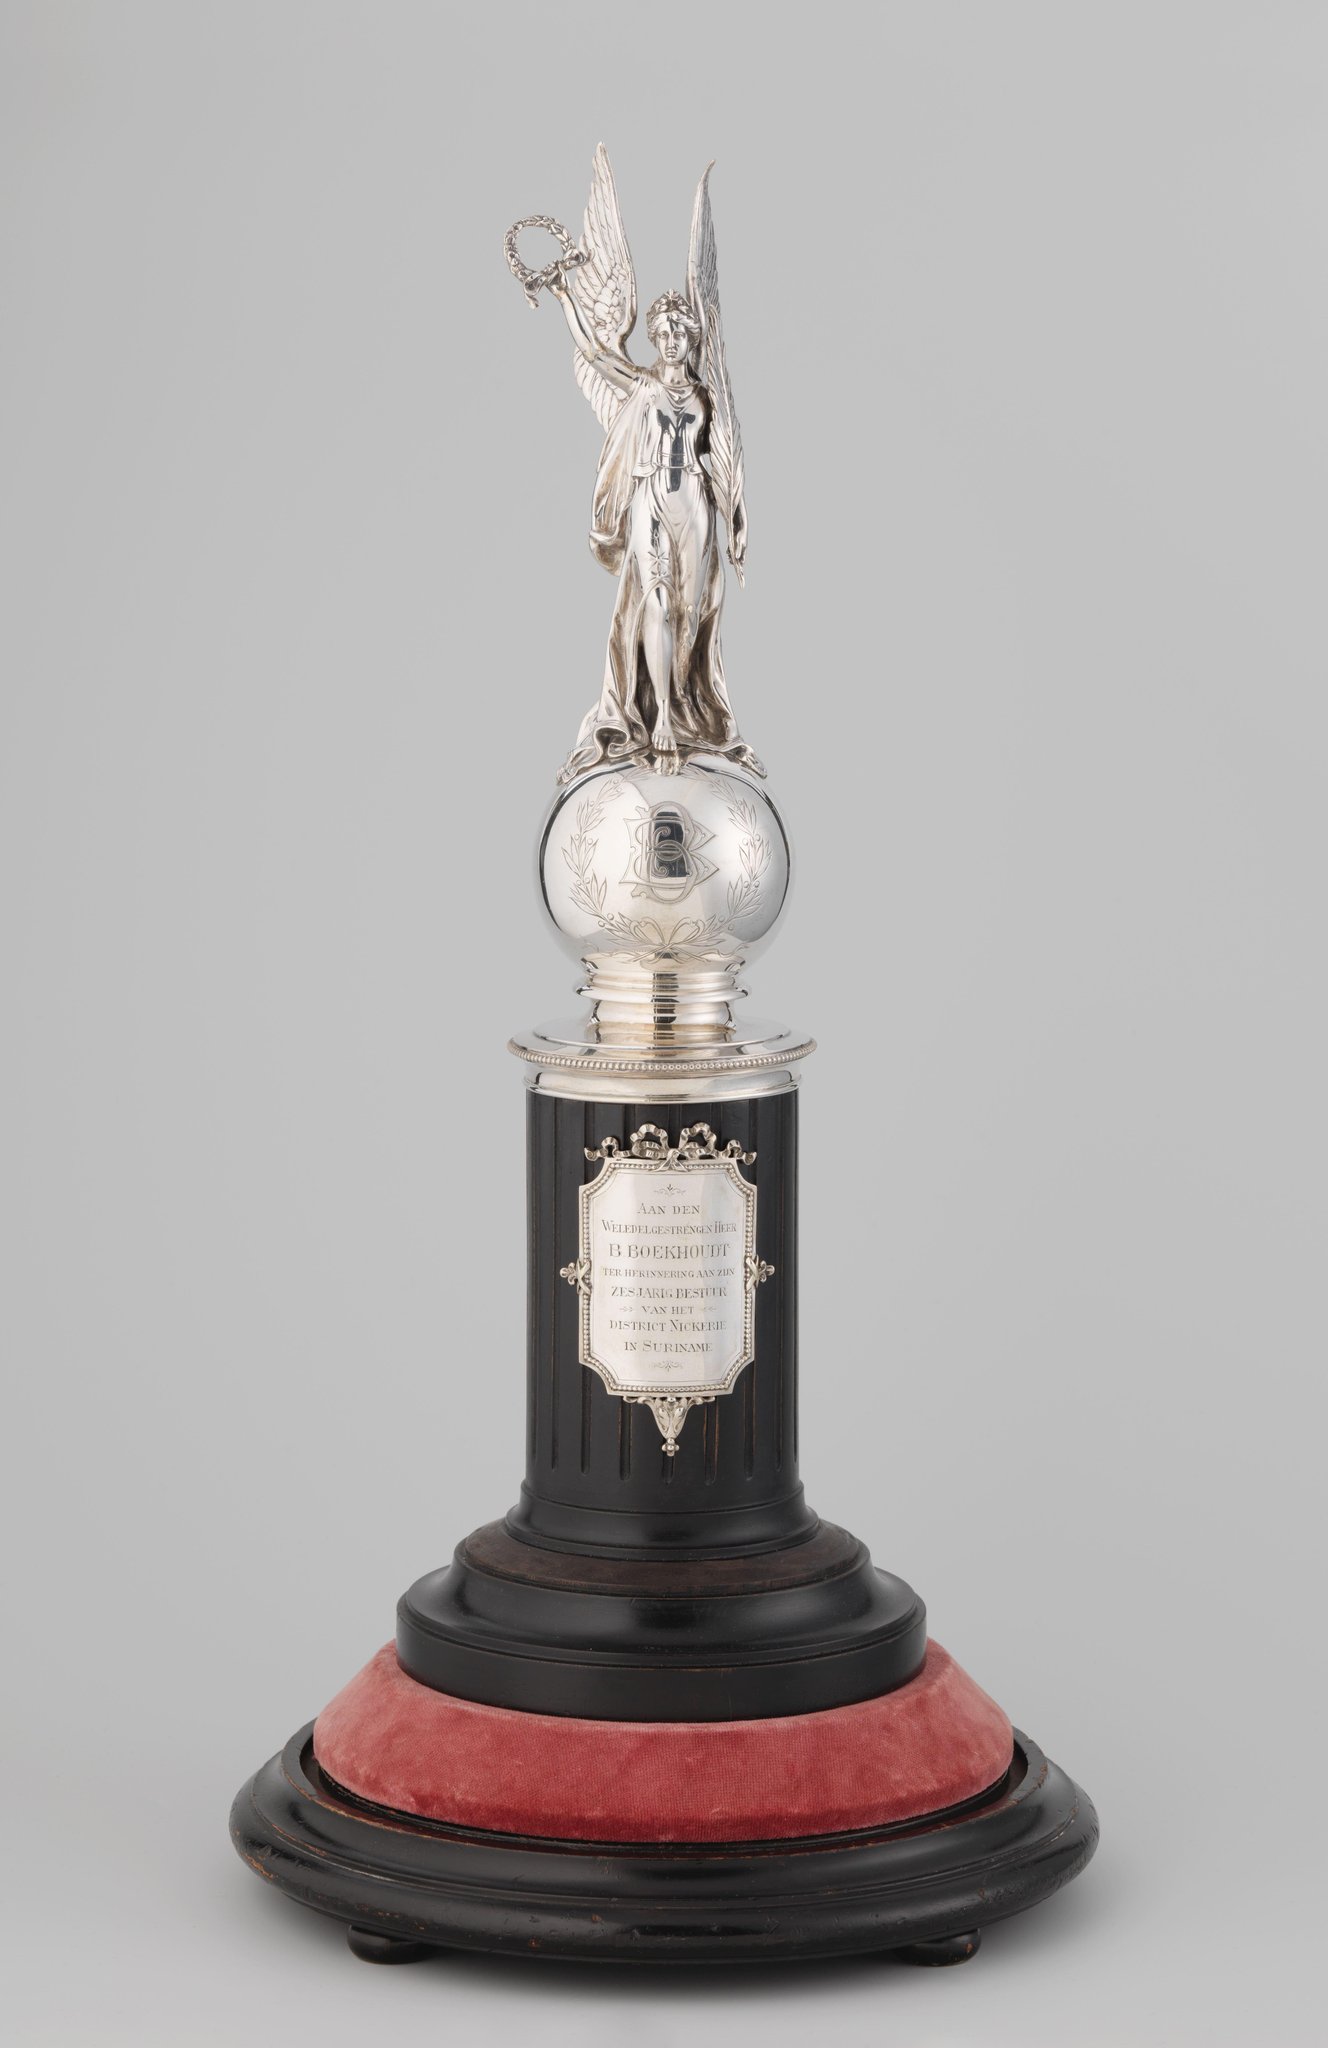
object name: figure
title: Beeld van het gedenkstuk voor B. Boekhoudt, districts-commissaris van Nickerie in Suriname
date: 1909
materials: silver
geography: the hague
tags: bernardus boekhoudt, nickerie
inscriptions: inscription: ‘Aan den weleldelgestrengen heer B. Boekhoudt ter herinnering aan zijn zesjarig bestuur van het district Nickerie in Suriname’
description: Beeld van het gedenkstuk, voorstellende een gevleugelde vrouw met in haar rechterhand een lauwerkrans en in haar linkerhand een palmtak uitgevoerd in zilver, staande op een zilveren bol waarop de initialen BB zijn gegraveerd.